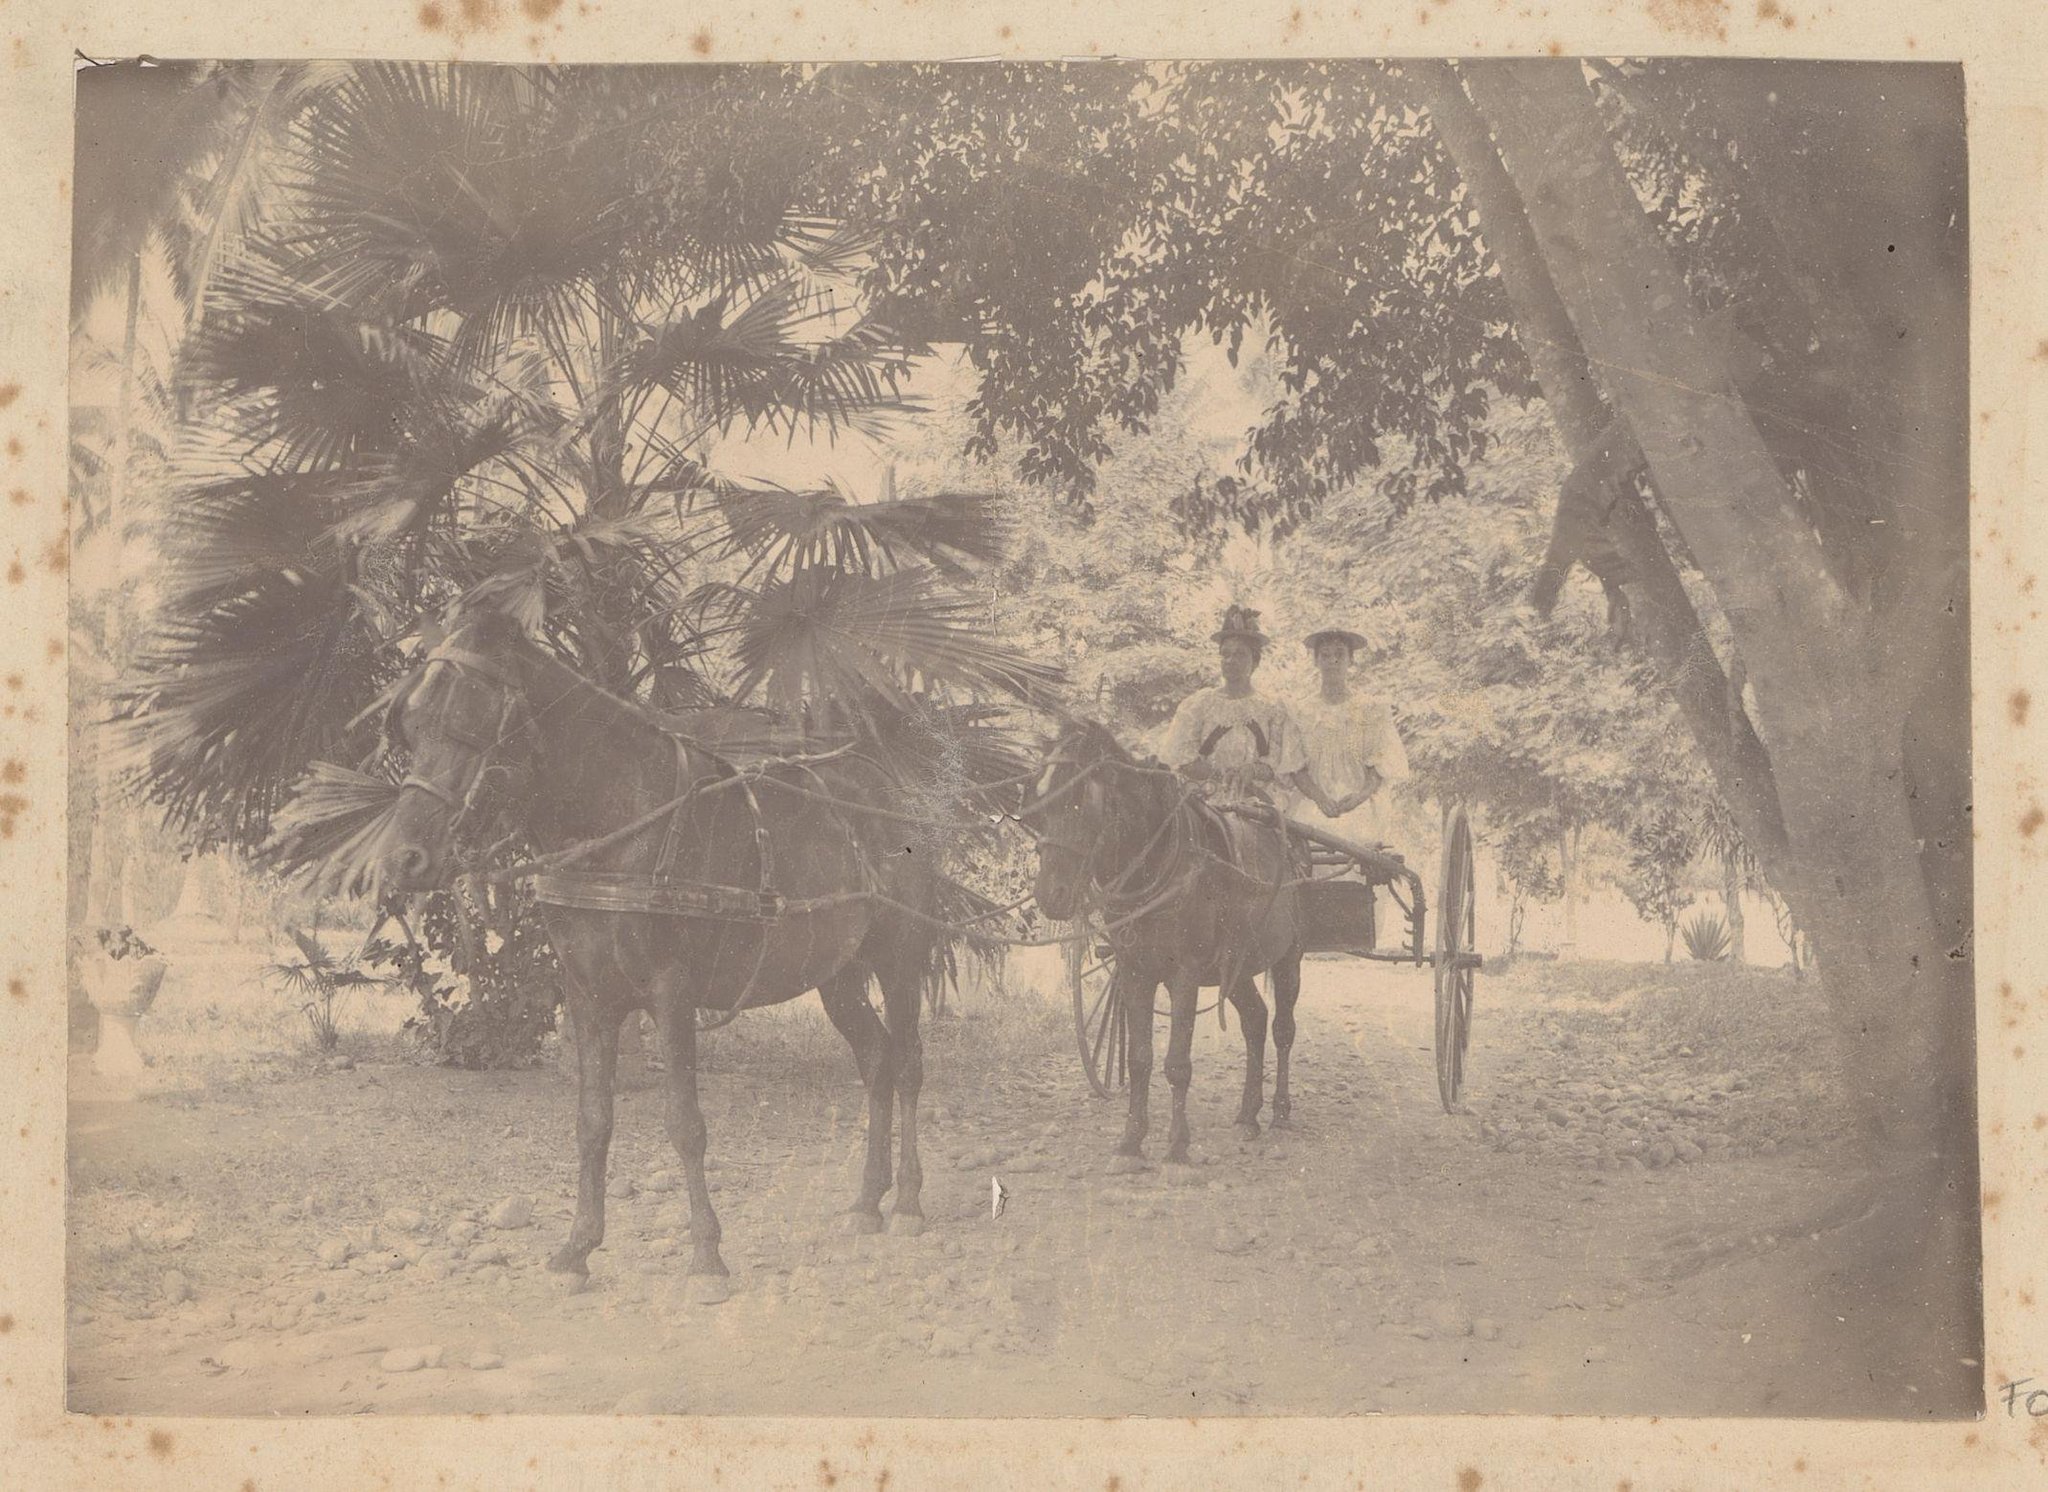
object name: album leaf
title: Twee Nederlandse vrouwen in een door paarden getrokken wagen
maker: Anonymous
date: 1890-1910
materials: photographic support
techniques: daylight paper print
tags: adult woman, horse, two-wheeled vehicle drawn by two animals, dutch east indies, the